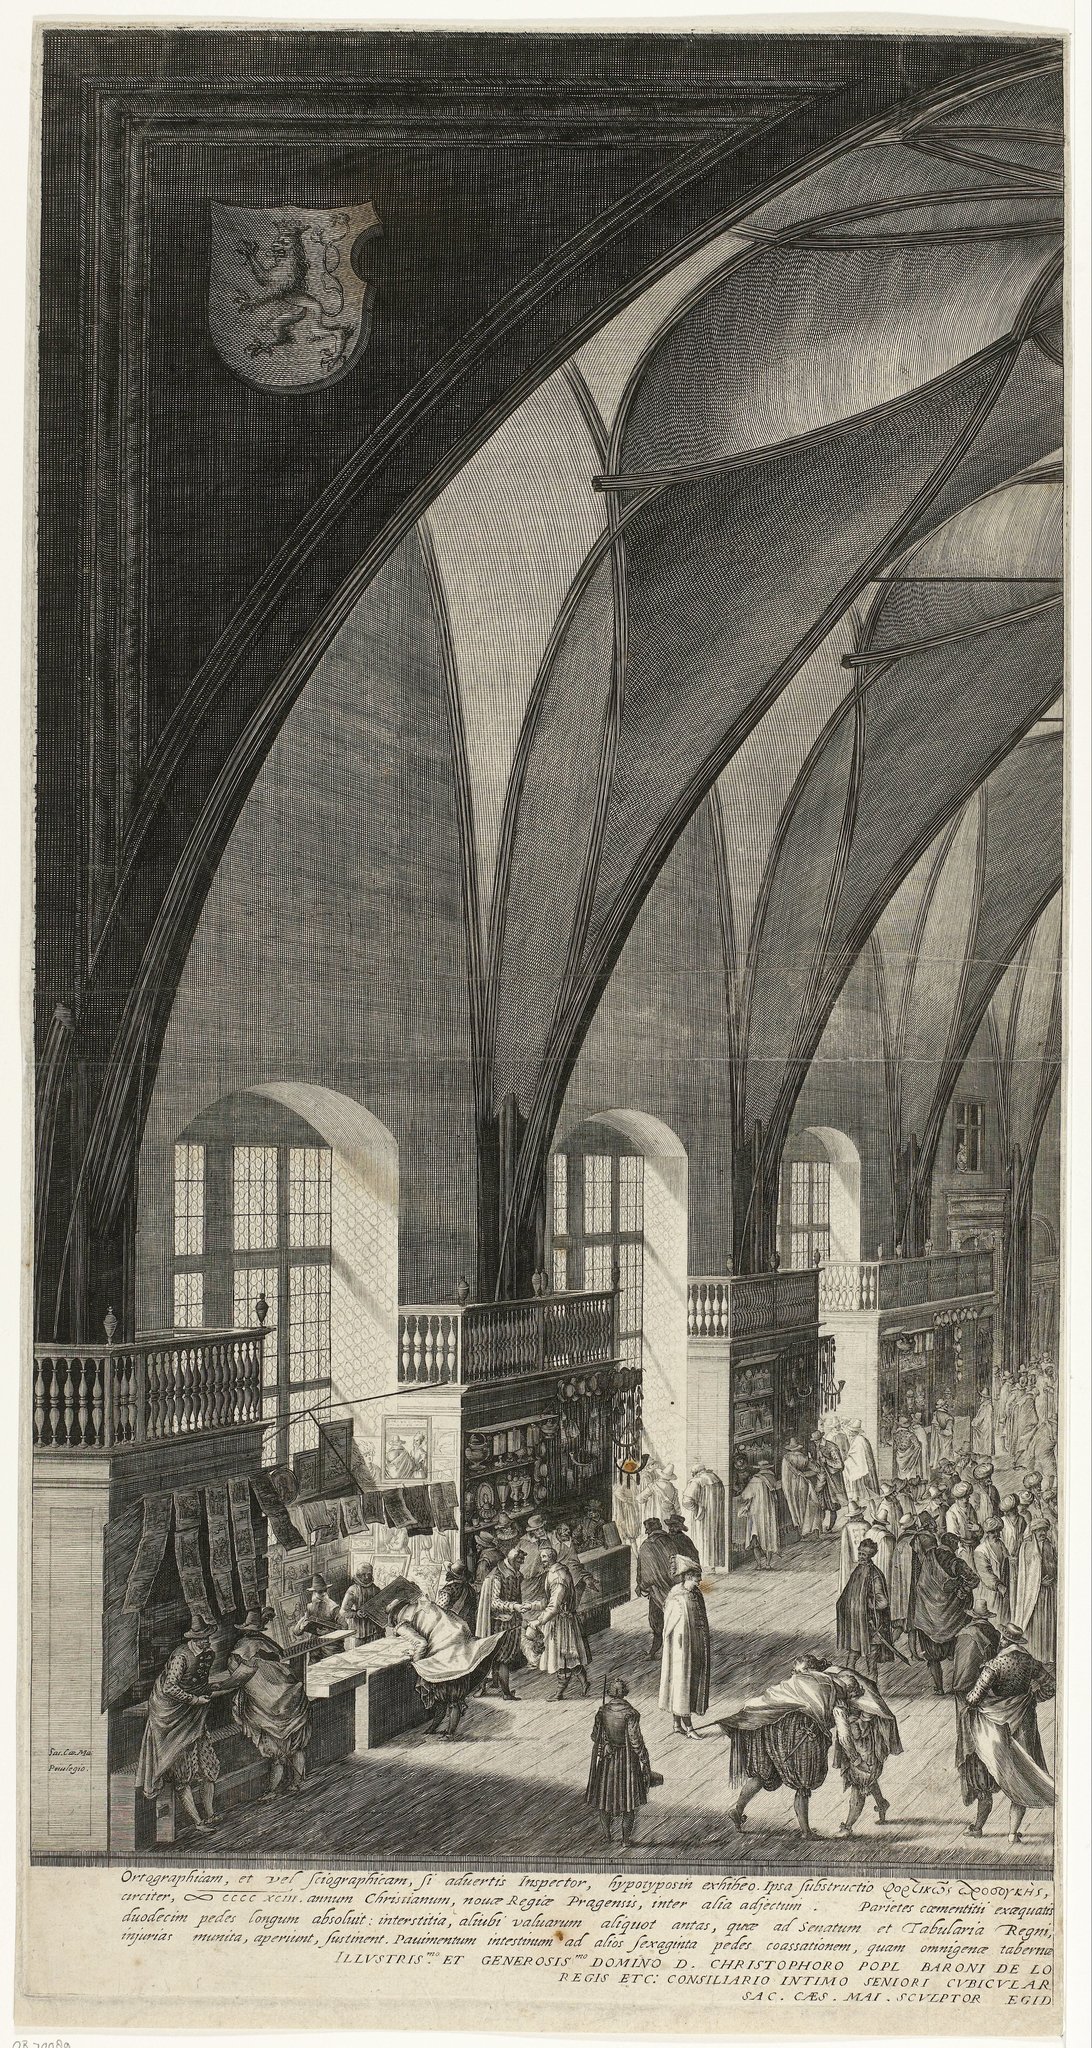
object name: print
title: Jaarmarkt in de Vladislavsky-zaal te Praag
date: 1607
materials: paper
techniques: engraving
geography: prague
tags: (annual) fair, trade fair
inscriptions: collector's mark: Lugt 2228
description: Jaarmarkt in de Vladislavsky-zaal van het oude koninklijke paleis te Praag. Links staan kramen waar kunstwerken en andere goederen te koop worden aangeboden. Er lopen veel bezoekers rond. Links- en rechtsboven een wapen. Onder de voorstelling een vijfregelige, Latijnse tekst en een drieregelige opdracht.